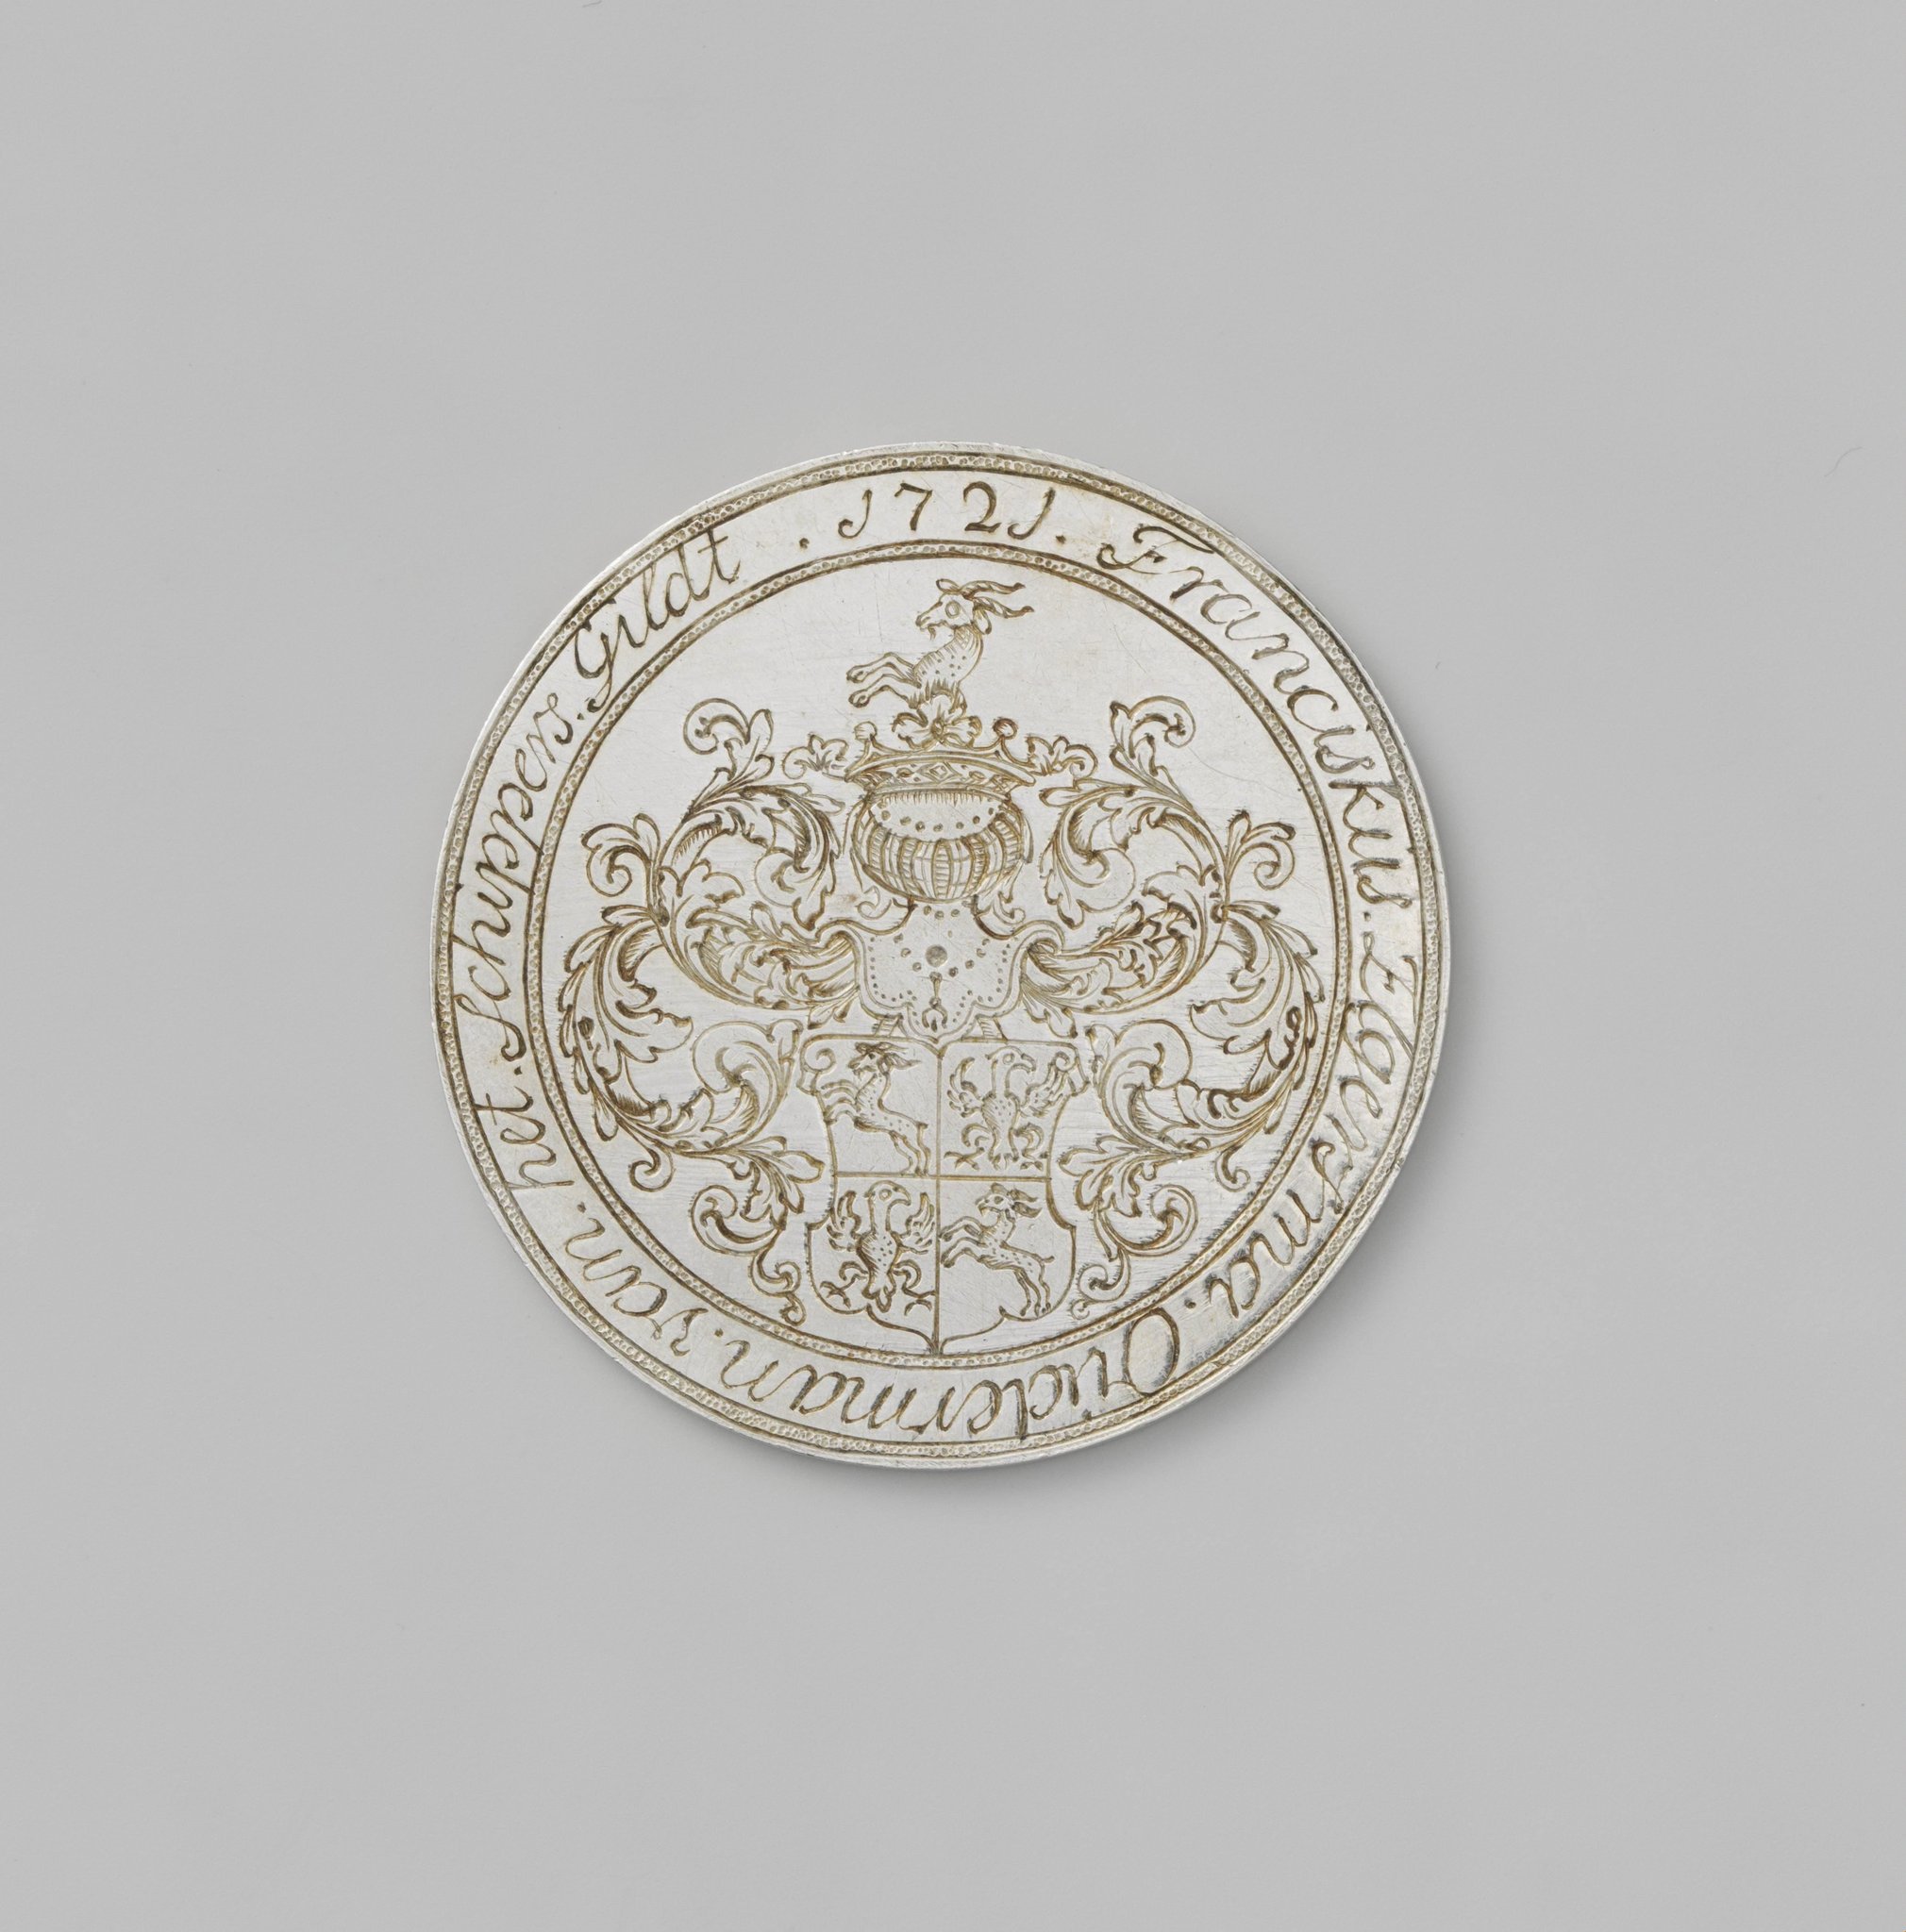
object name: overmanspenning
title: Bargemen, Bolsward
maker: Anonymous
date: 1721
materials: silver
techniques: engraving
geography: netherlands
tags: mayor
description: Guild medals Members of trade guilds had to identify themselves with a medal at their meetings.